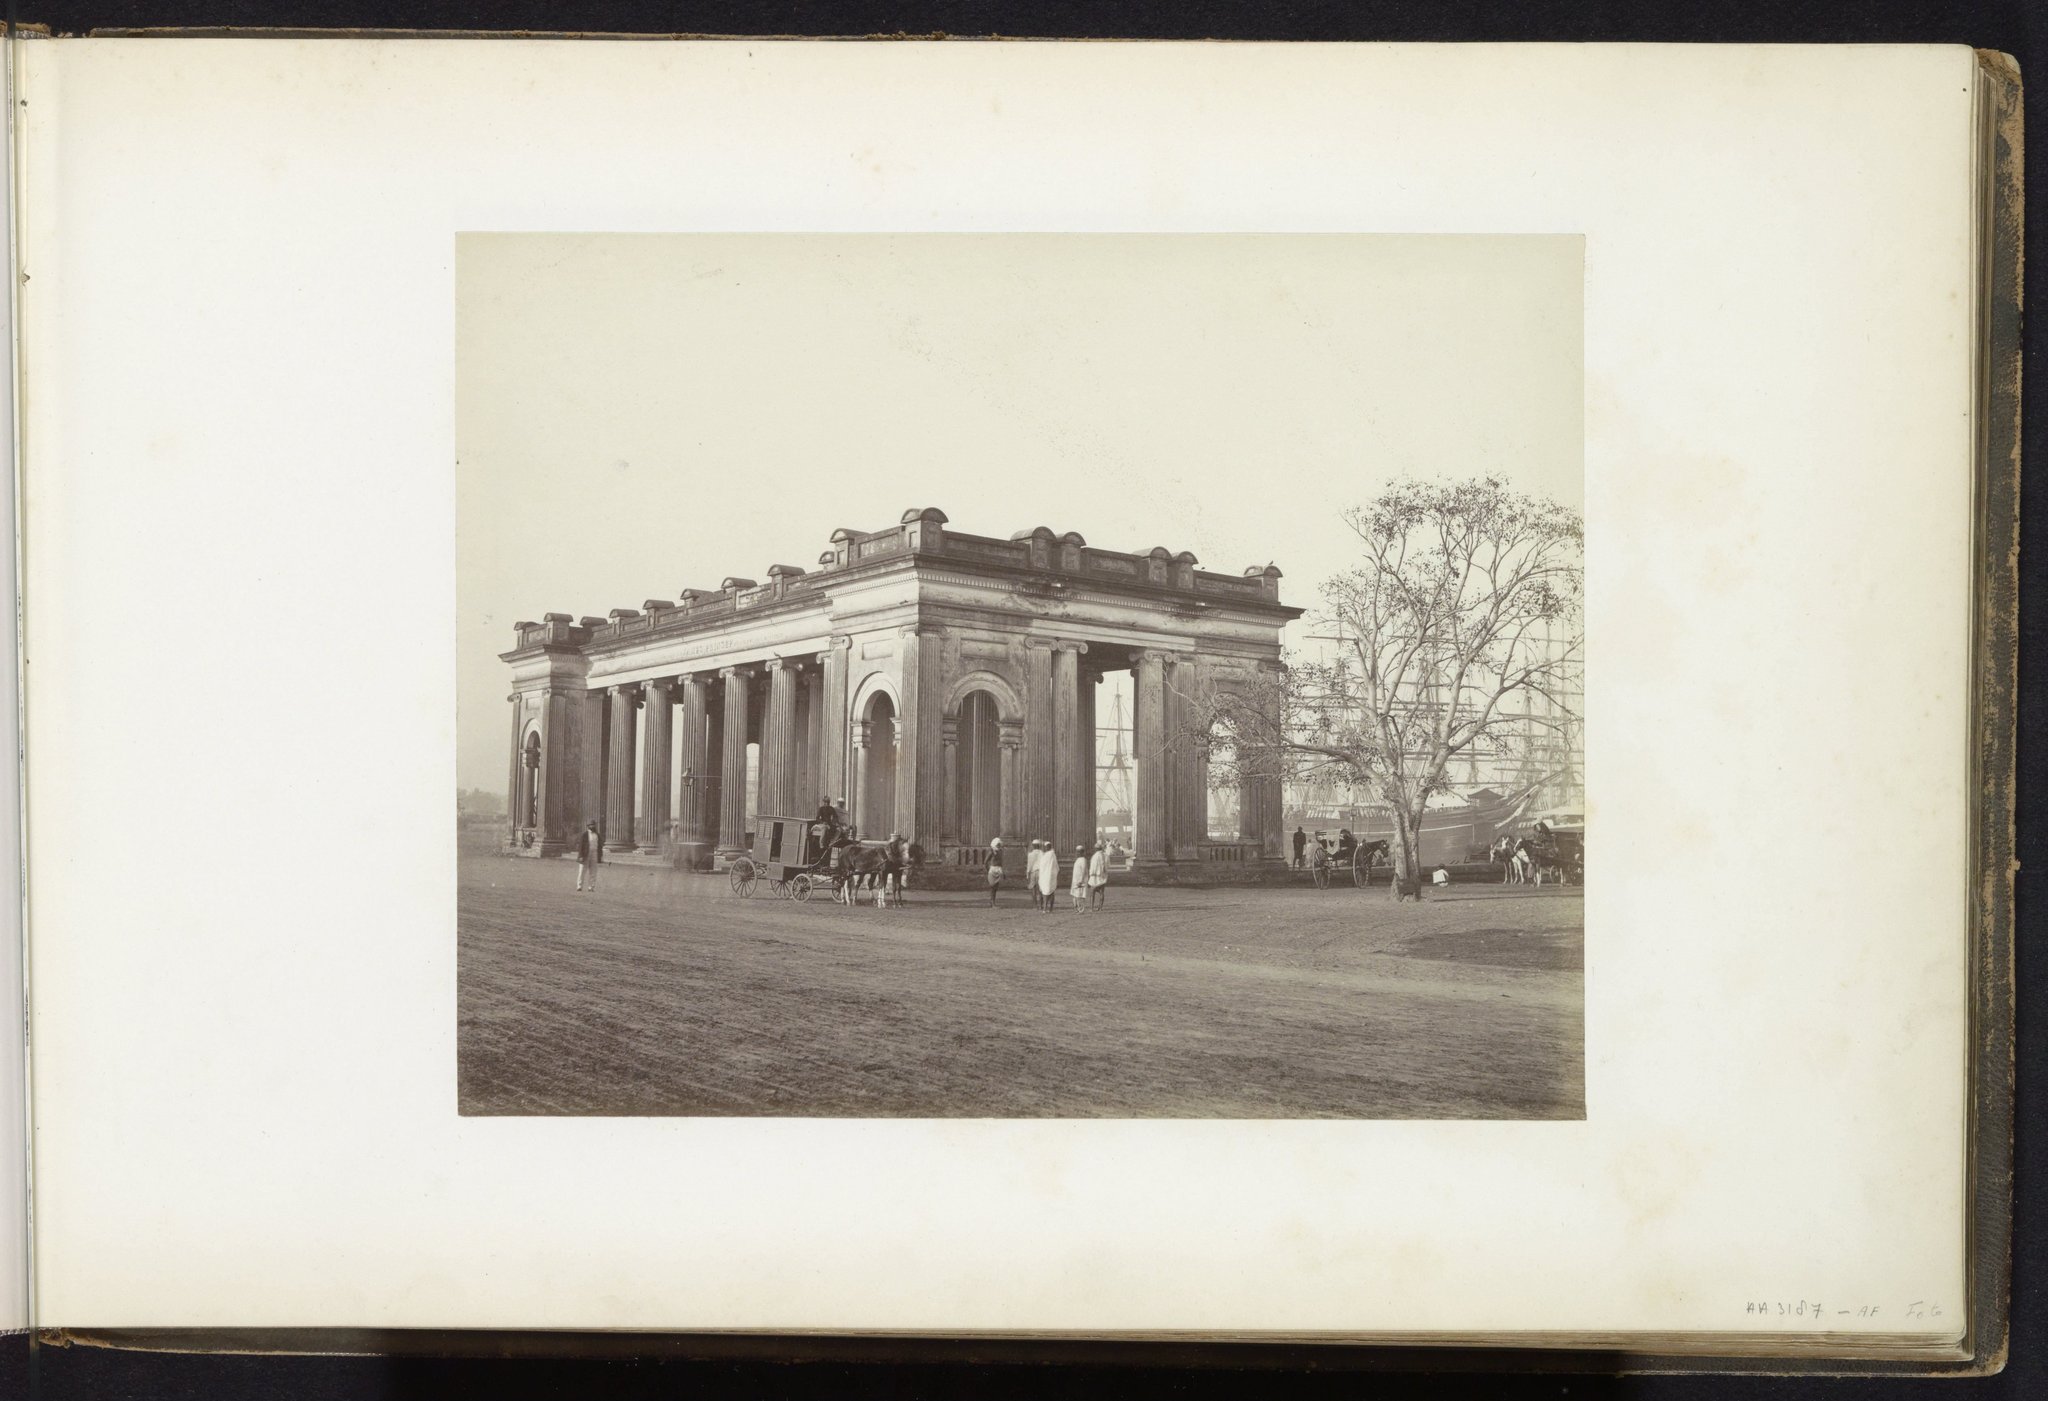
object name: album leaf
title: Prinsep Ghat on the banks of the Hugli river in Kolkata, West Bengal, India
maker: Anonymous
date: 1865-1875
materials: photographic support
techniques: albumen print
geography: kolkata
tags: exterior ~ representation of a building, quay (+ city(-scape) with figures, staffage)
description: Prinsep Ghat is vernoemd naar de Engelse metallurg, taalkundige, antiquair en oriëntalist James Prinsep (1799-1840) die in India werkzaam was.